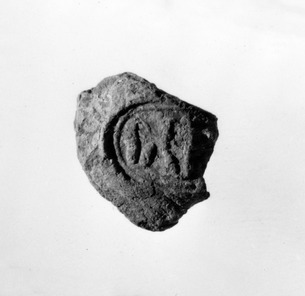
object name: sealing, nebmaatre, amenhotep iii, thoth, double crown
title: Document Sealing With the Throne Name of Amenhotep III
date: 1390-1352 BCE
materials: mud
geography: egypt